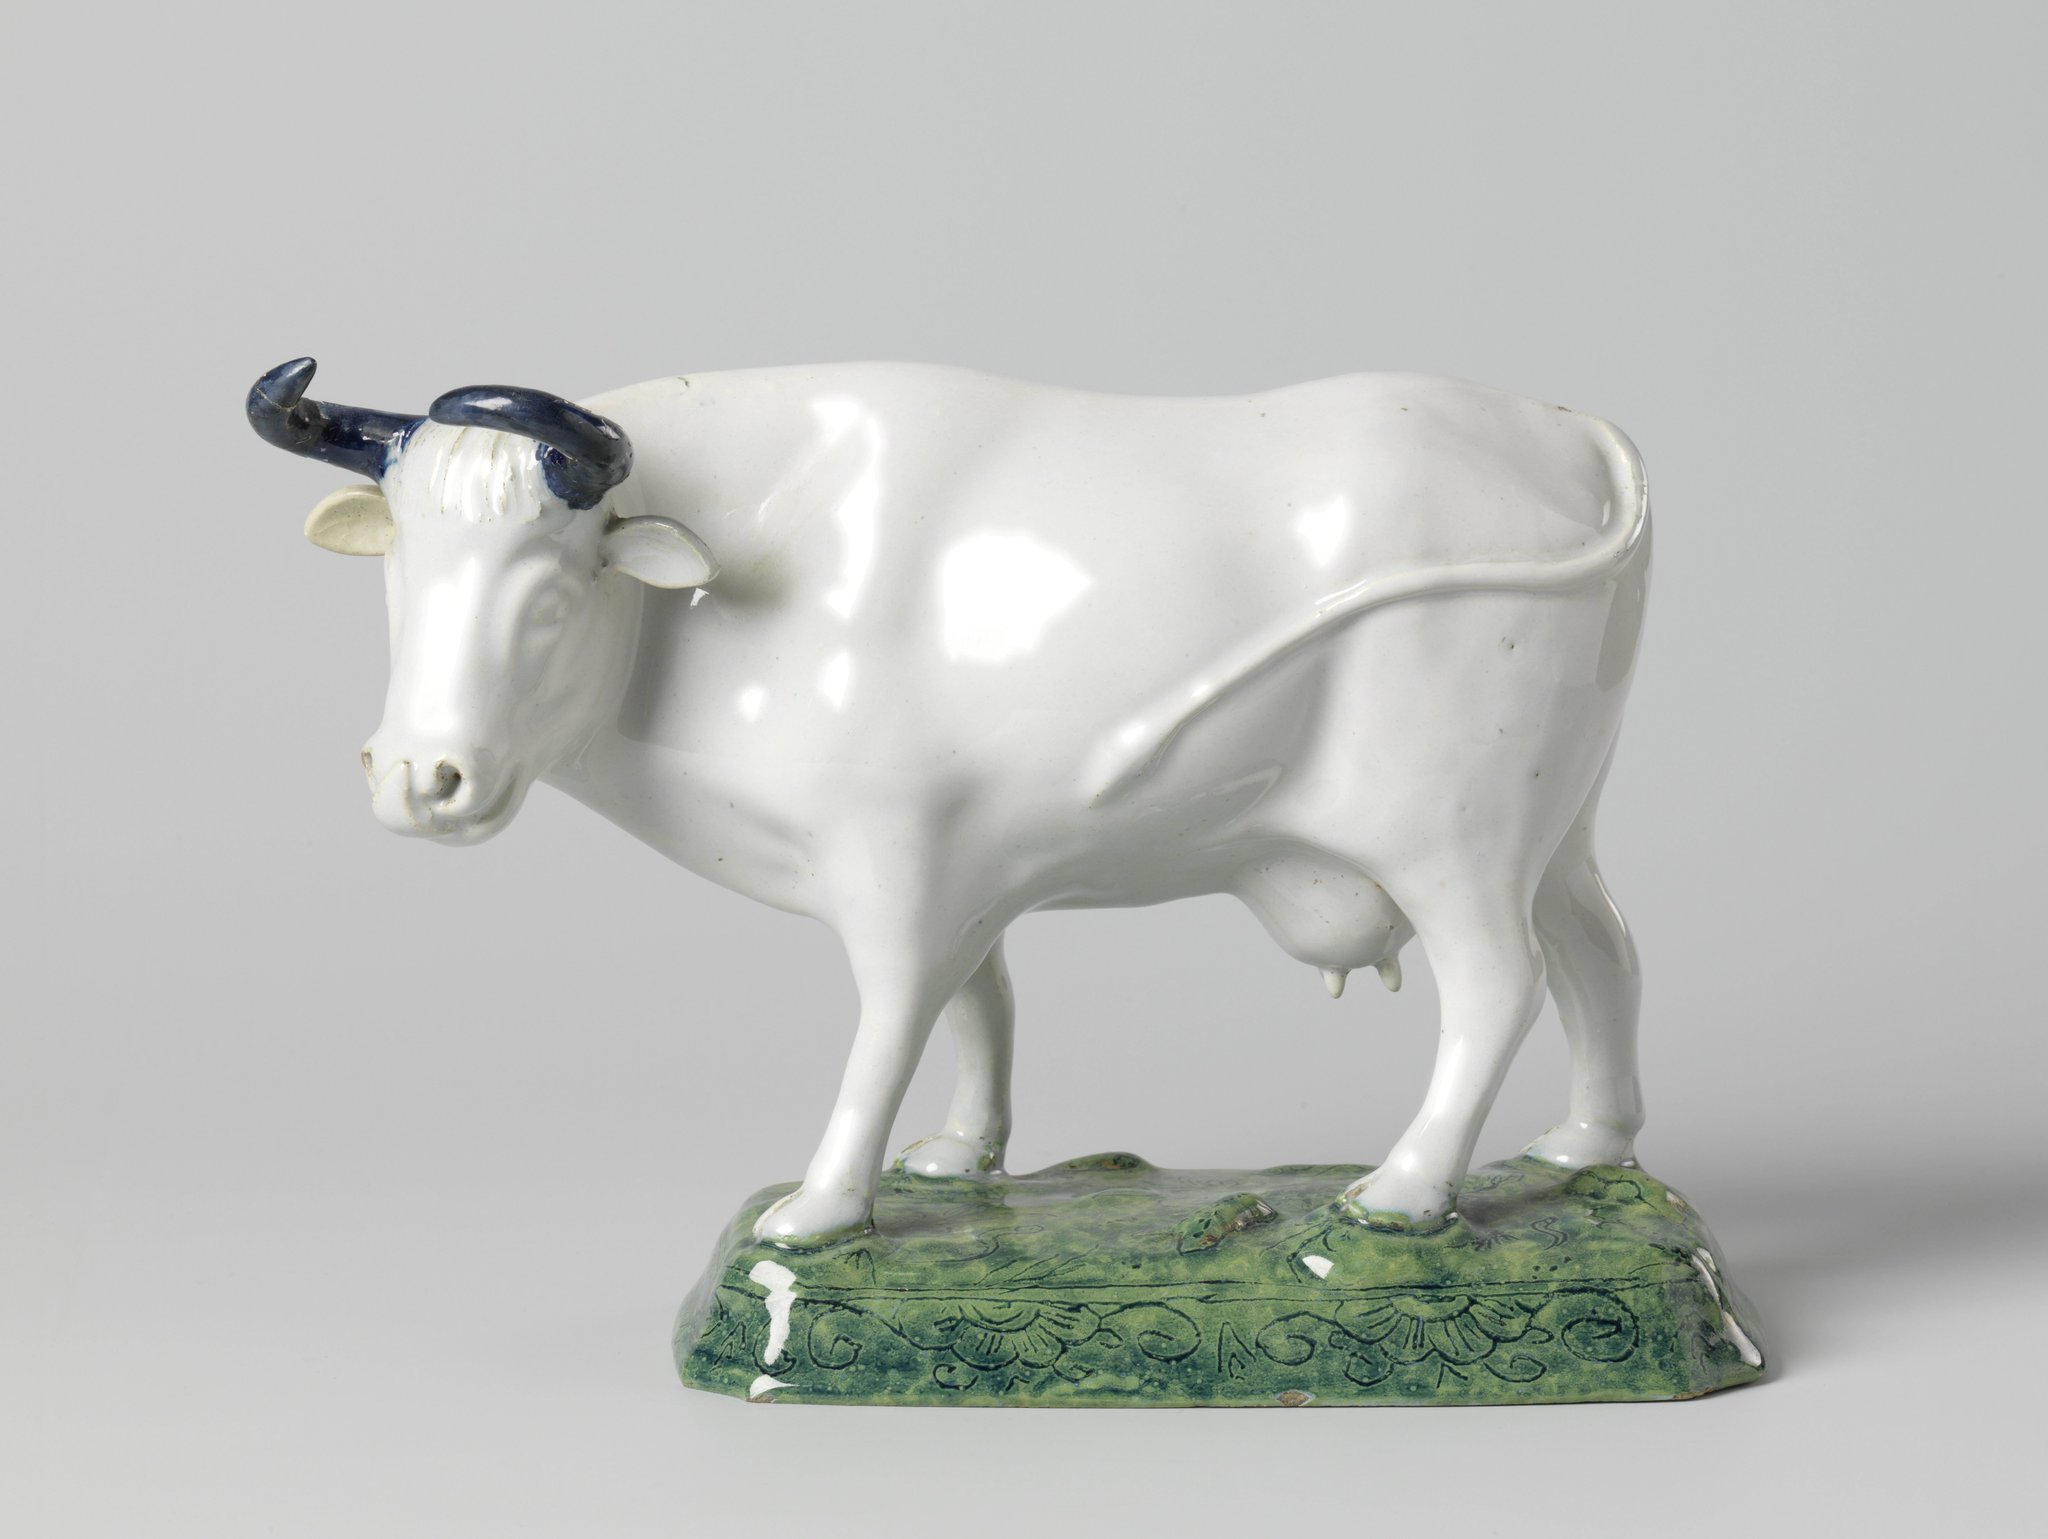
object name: decoratief object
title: Koe met blauwe horens, op rechthoekig voetstuk met afgeschuinde hoeken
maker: Anonymous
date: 1750-1780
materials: earthenware, gold, glaze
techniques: painted, polychromy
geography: delft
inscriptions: mark: ‘figuratief teken bloem’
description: Beeld van faience. Op een rechthoekig voetstuk met afgeschuinde hoeken staat een koe. De koe heeft blauw geschilderde horens en is verder ongedecoreerd. De koe heeft het hoofd naar links gewend. Het voetstuk is groen geschilderd met zwarte bloemen. Het beeld is gemerkt.